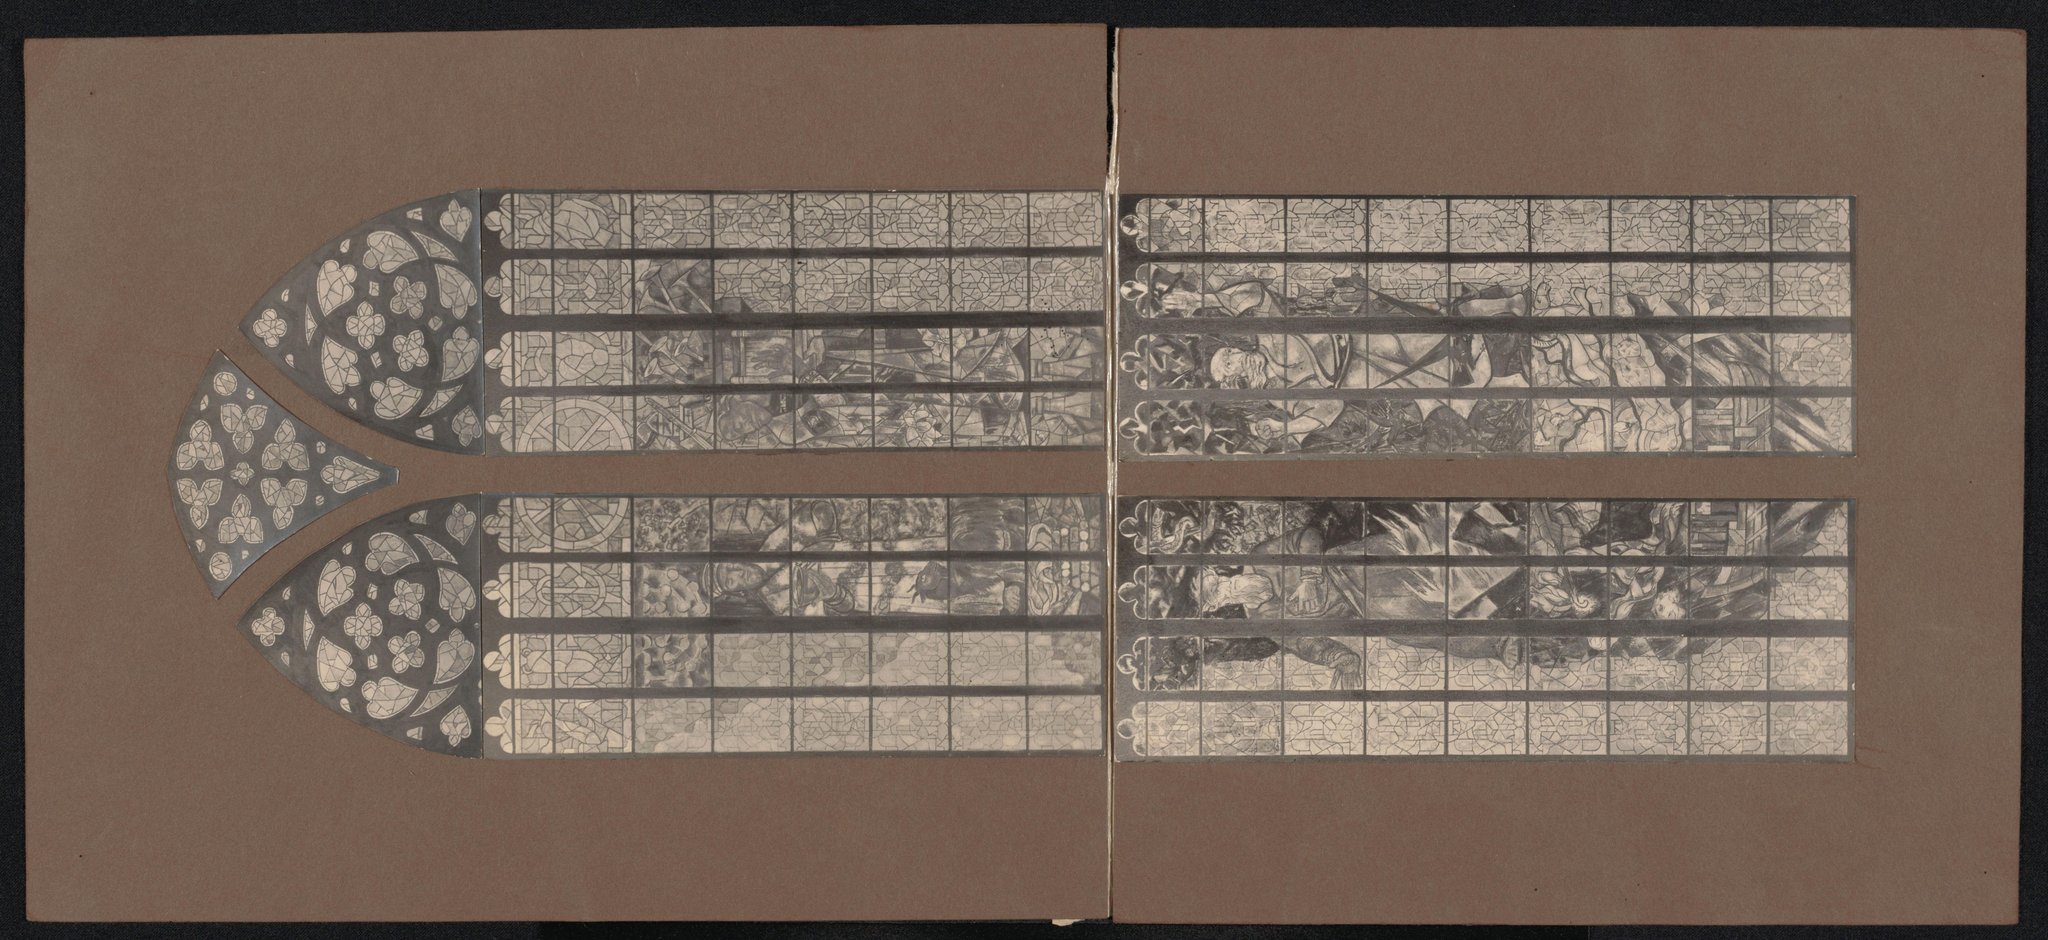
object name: photograph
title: Cartons voor glas in lood ramen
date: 1878-1938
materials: cardboard, photographic support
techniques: photography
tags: applied arts, arts and crafts; industrial design